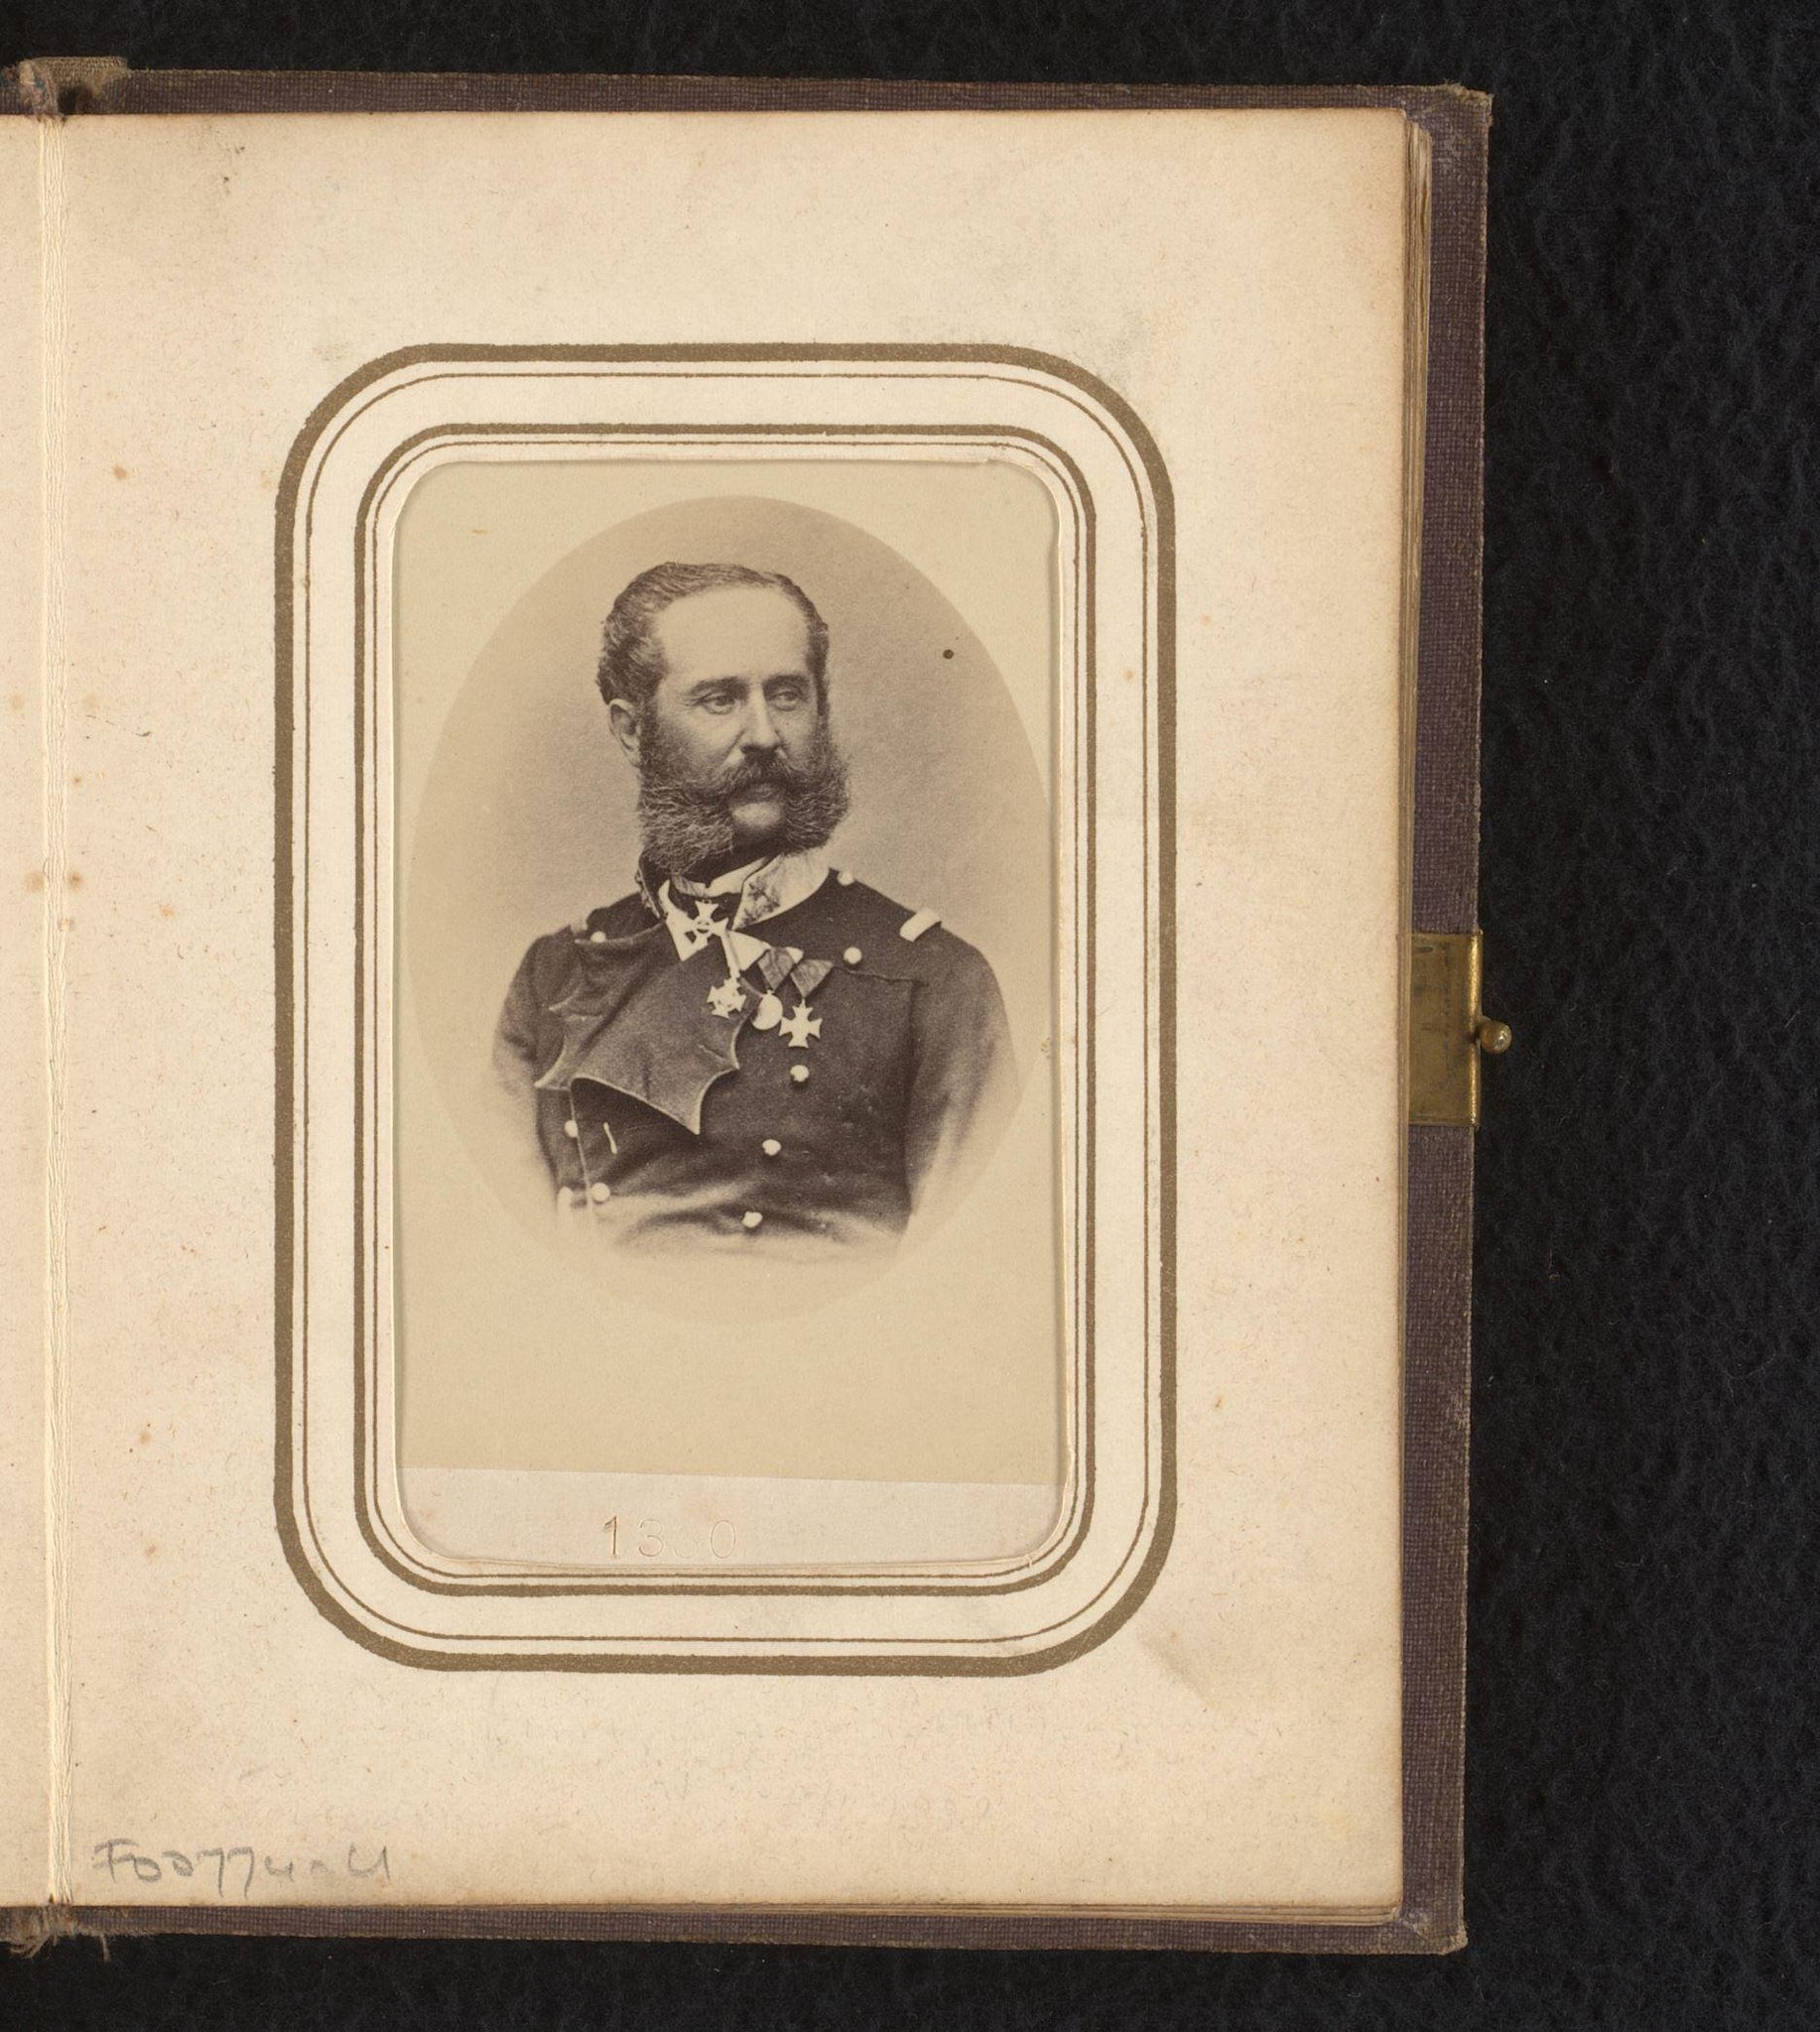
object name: carte de visite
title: Portret van een militair in uniform, vermoedelijk uit Duitsland of Oostenrijk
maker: Anonymous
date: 1850-1900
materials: cardboard, photographic support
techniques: albumen print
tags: ranks in the army, historical persons, (military) uniforms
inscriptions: number: ‘1330’